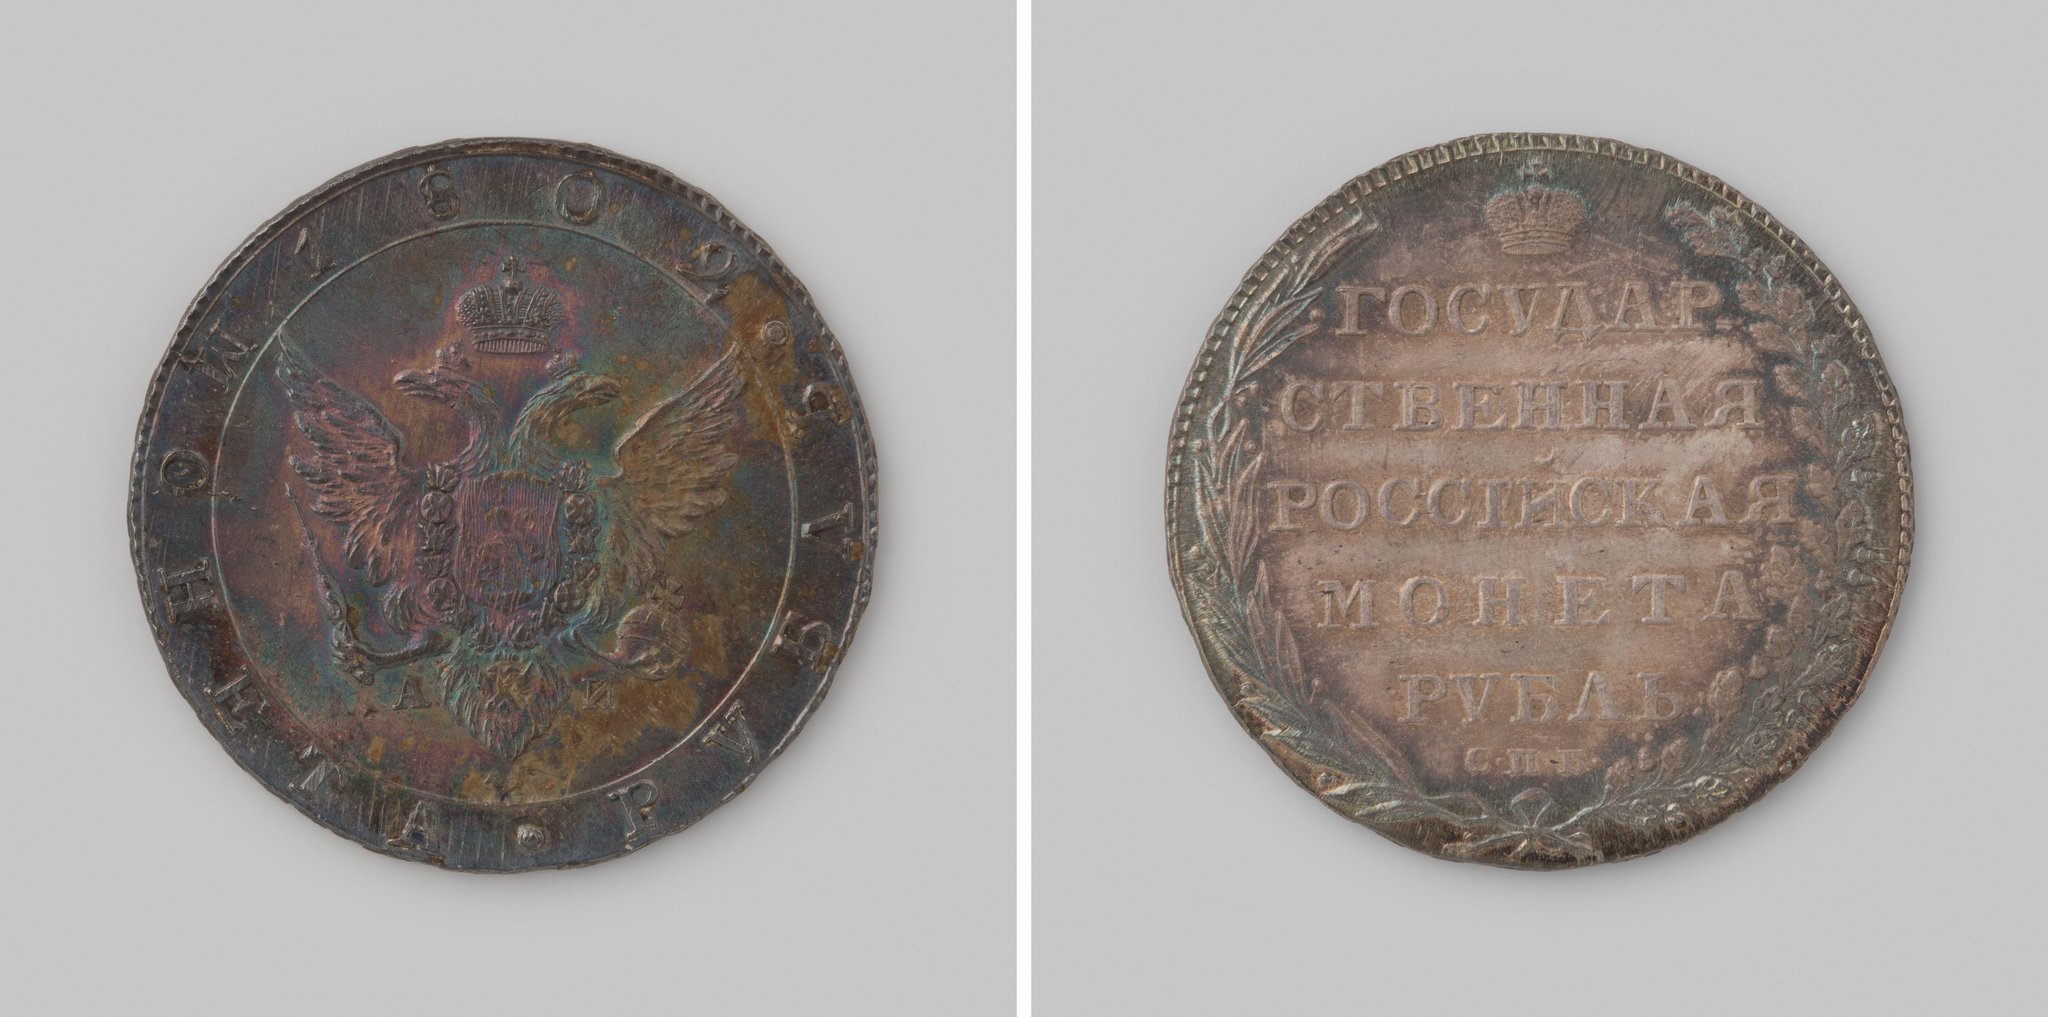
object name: coin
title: Roebel uit Rusland van tsaar Alexander I, 1802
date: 1802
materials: silver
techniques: striking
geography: sint-petersburg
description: Zilveren munt. Voorzijde: dubbelkoppige gekroonde adelaar met gespreide vleugels, met op zijn borst door ridderorde omhangen wapenschild en met in zijn poten scepter en bol met daarop kruis. Boven de adelaar een kroon. Waarde-aanduiding en jaartal in het omschrift. Keerzijde: binnen twee samengebonden takken onder een kroon opschrift in vijf regels, waarvan de onderste regel waarde-aanduiding. Daaronder de letters S, P en B in Cyrillisch schrift. Opliggend randschrift.